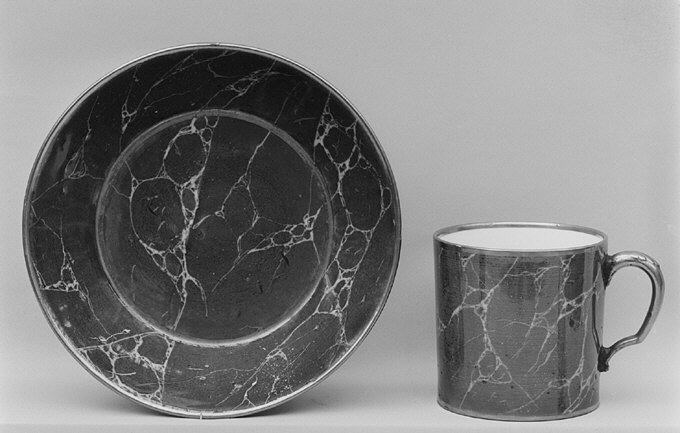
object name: cup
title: Cup (gobelet litron)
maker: sèvres manufactory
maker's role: manufactory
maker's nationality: french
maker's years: 1740-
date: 1781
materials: hard paste porcelain